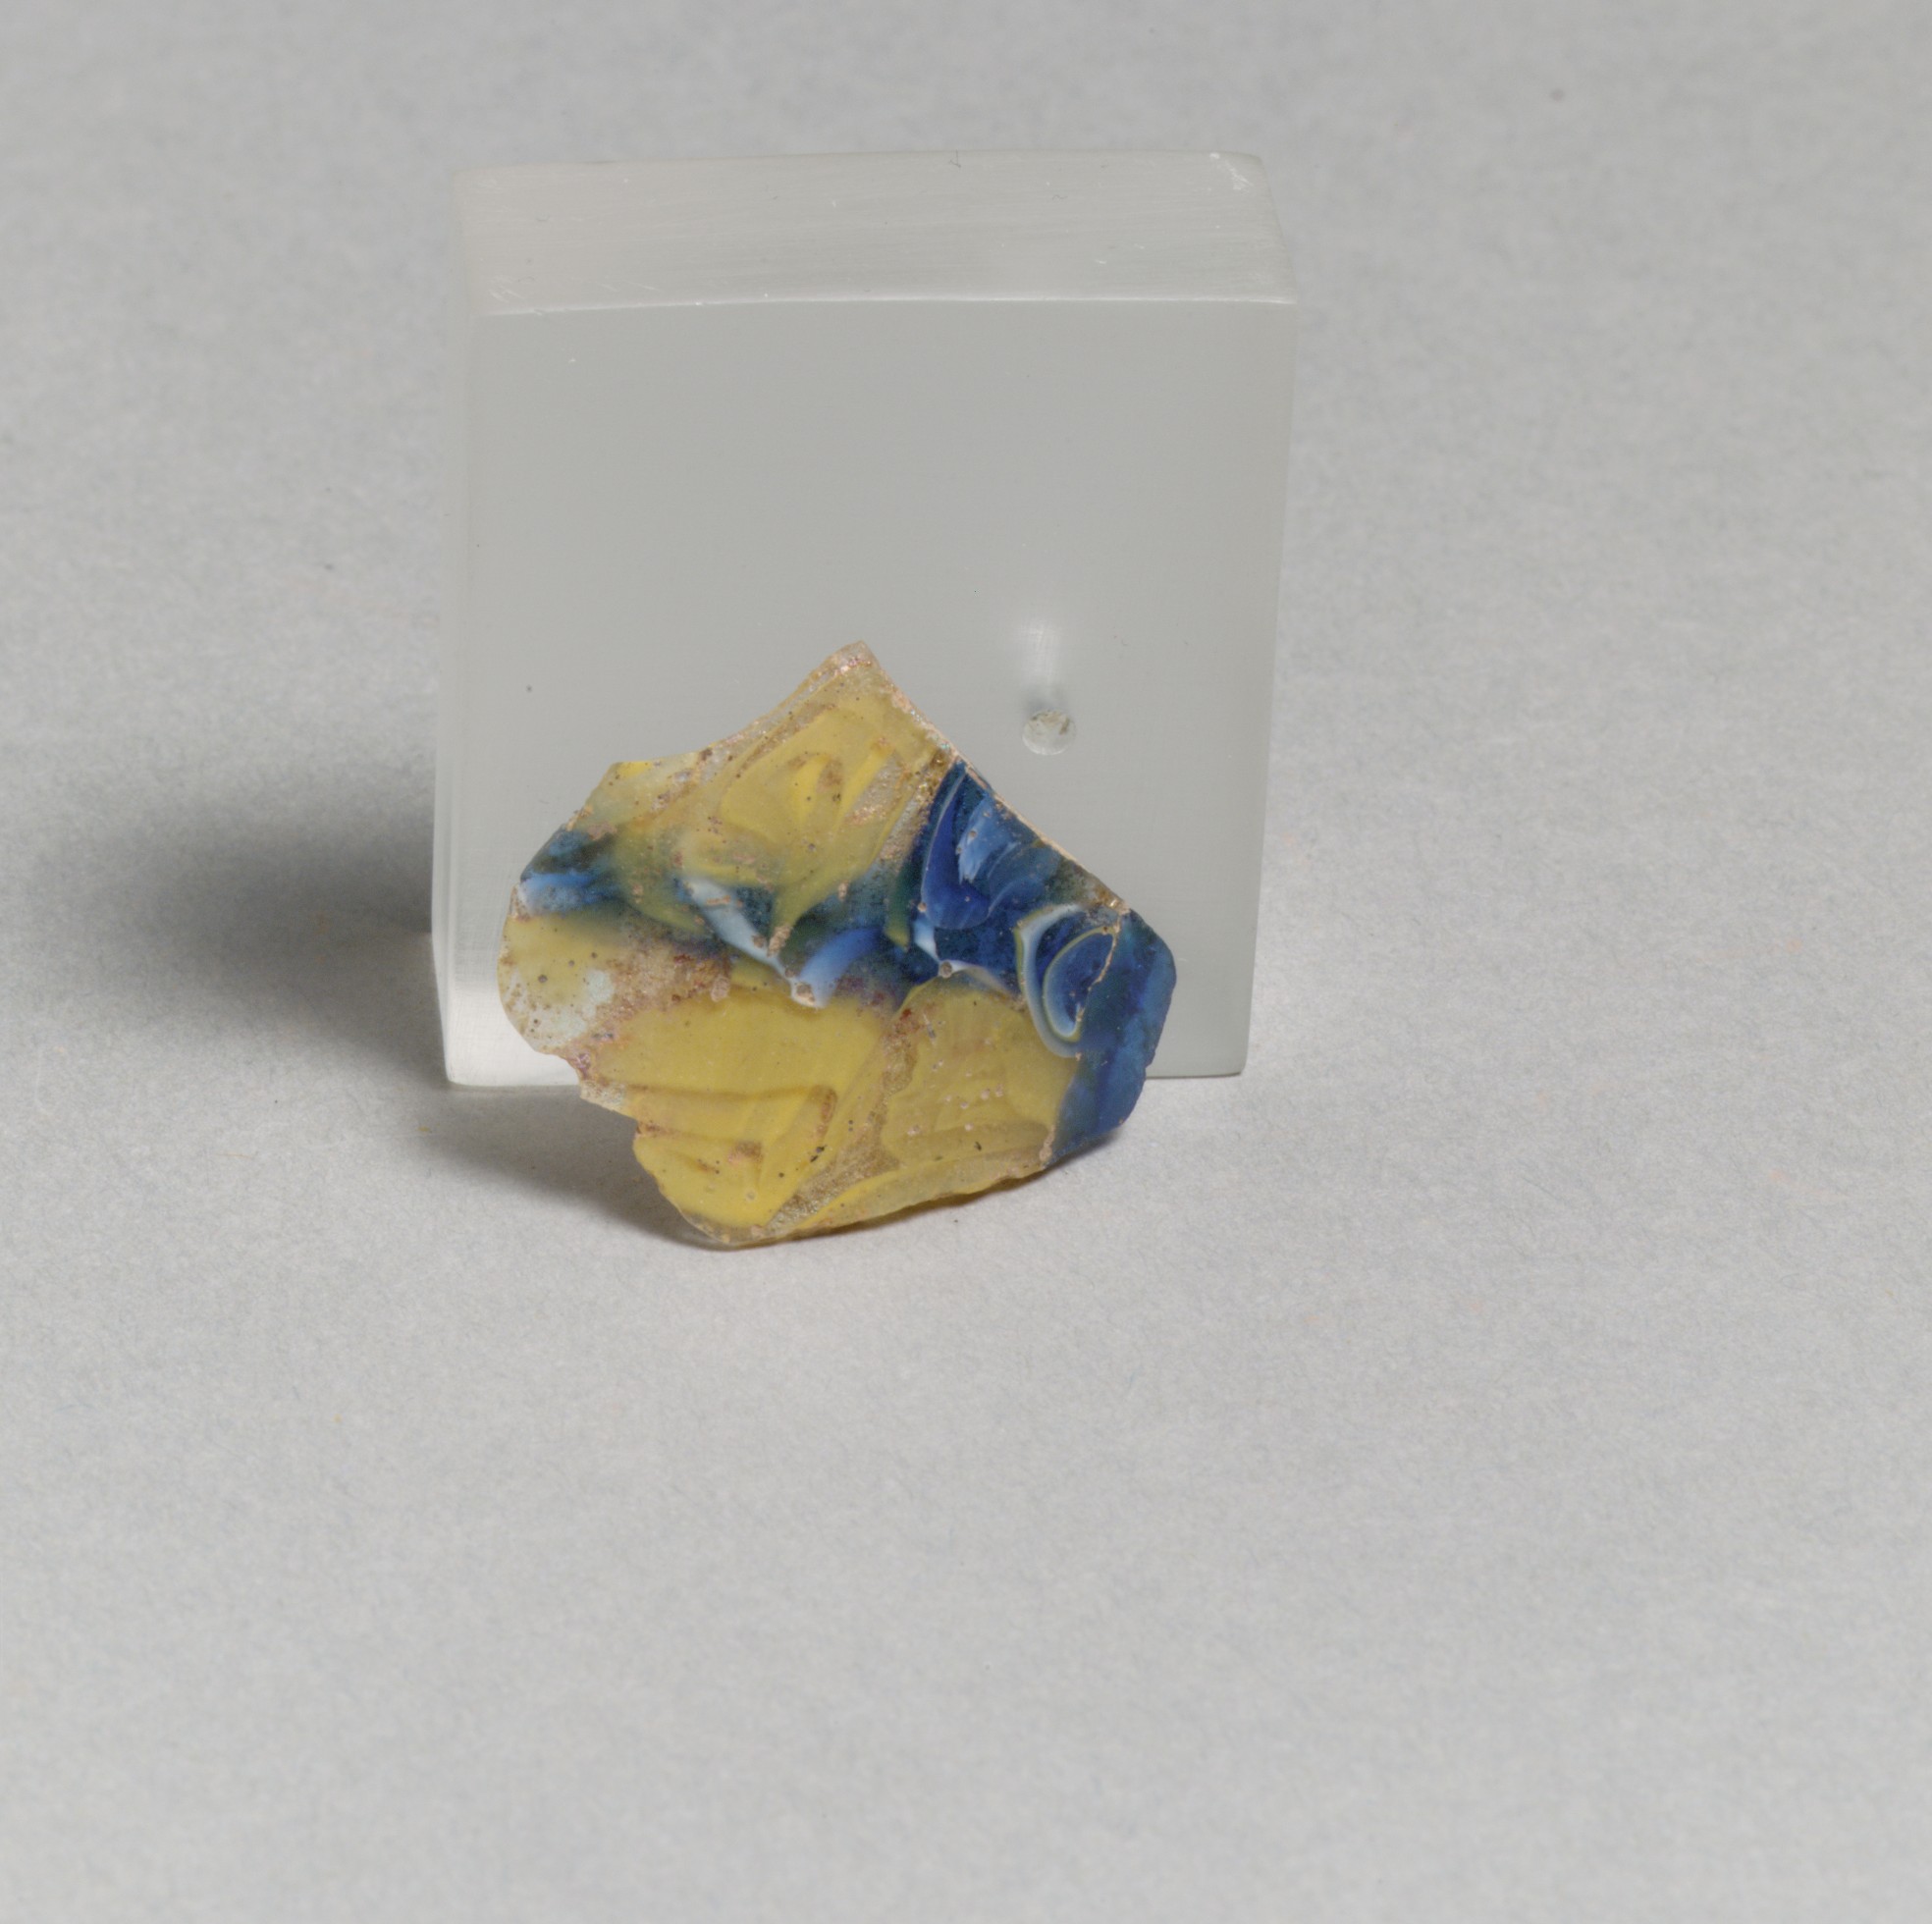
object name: fragment, mosaic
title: Glass mosaic fragment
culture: roman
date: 34 BCE-33 CE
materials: glass